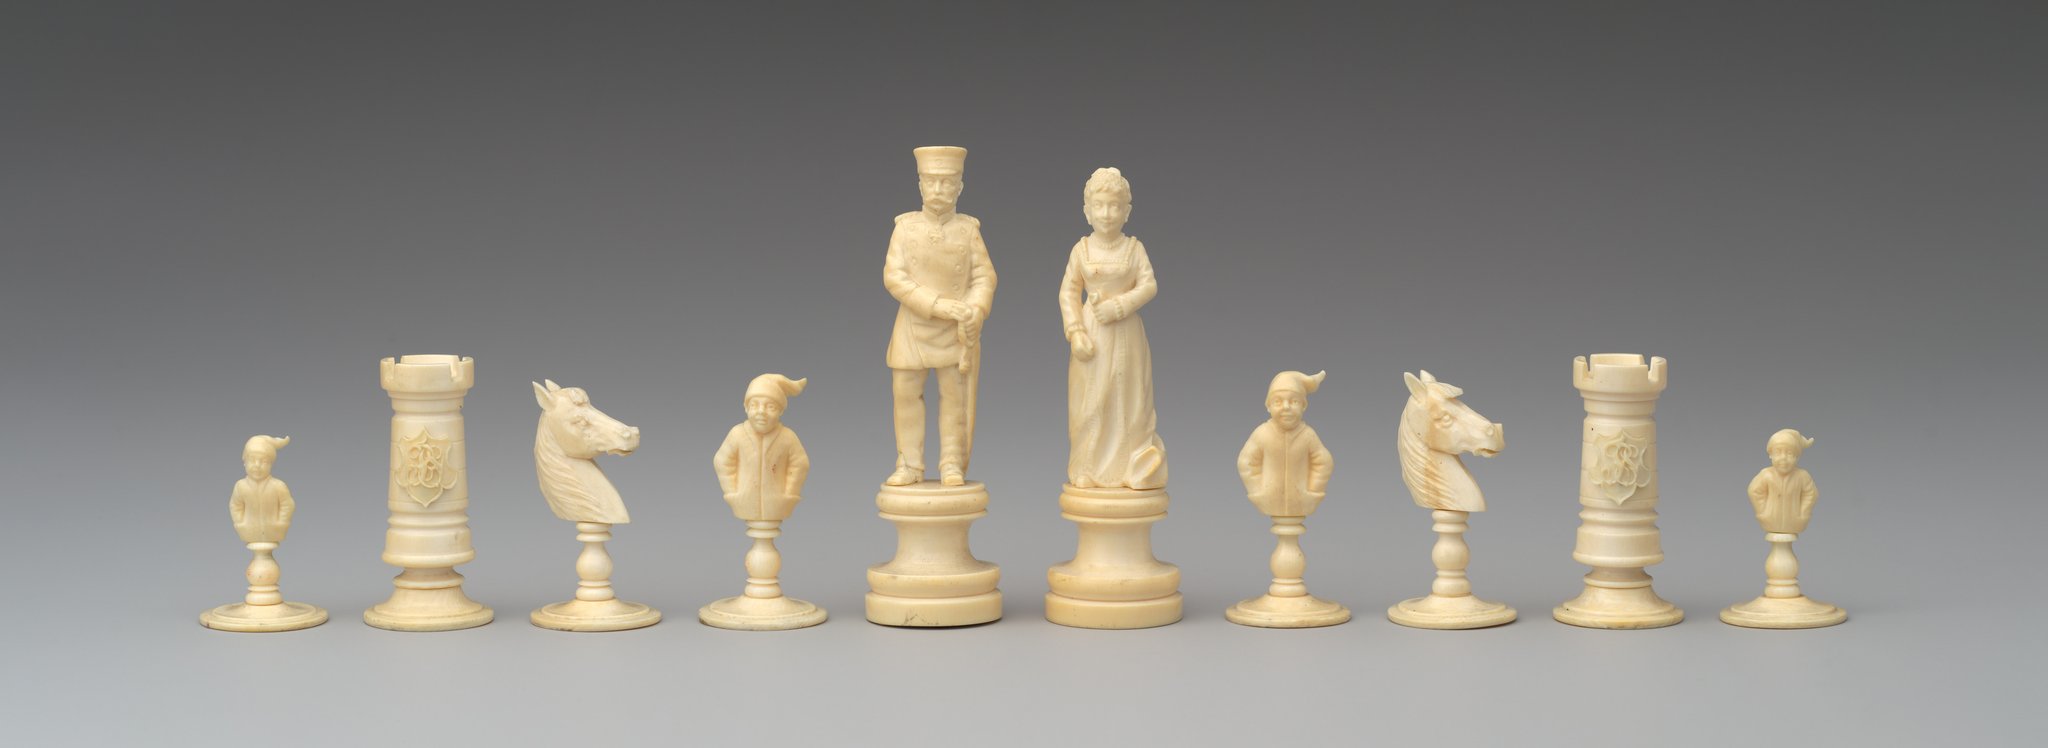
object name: chessman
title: Chessmen (32)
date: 1867-1900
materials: ivory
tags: chess,games